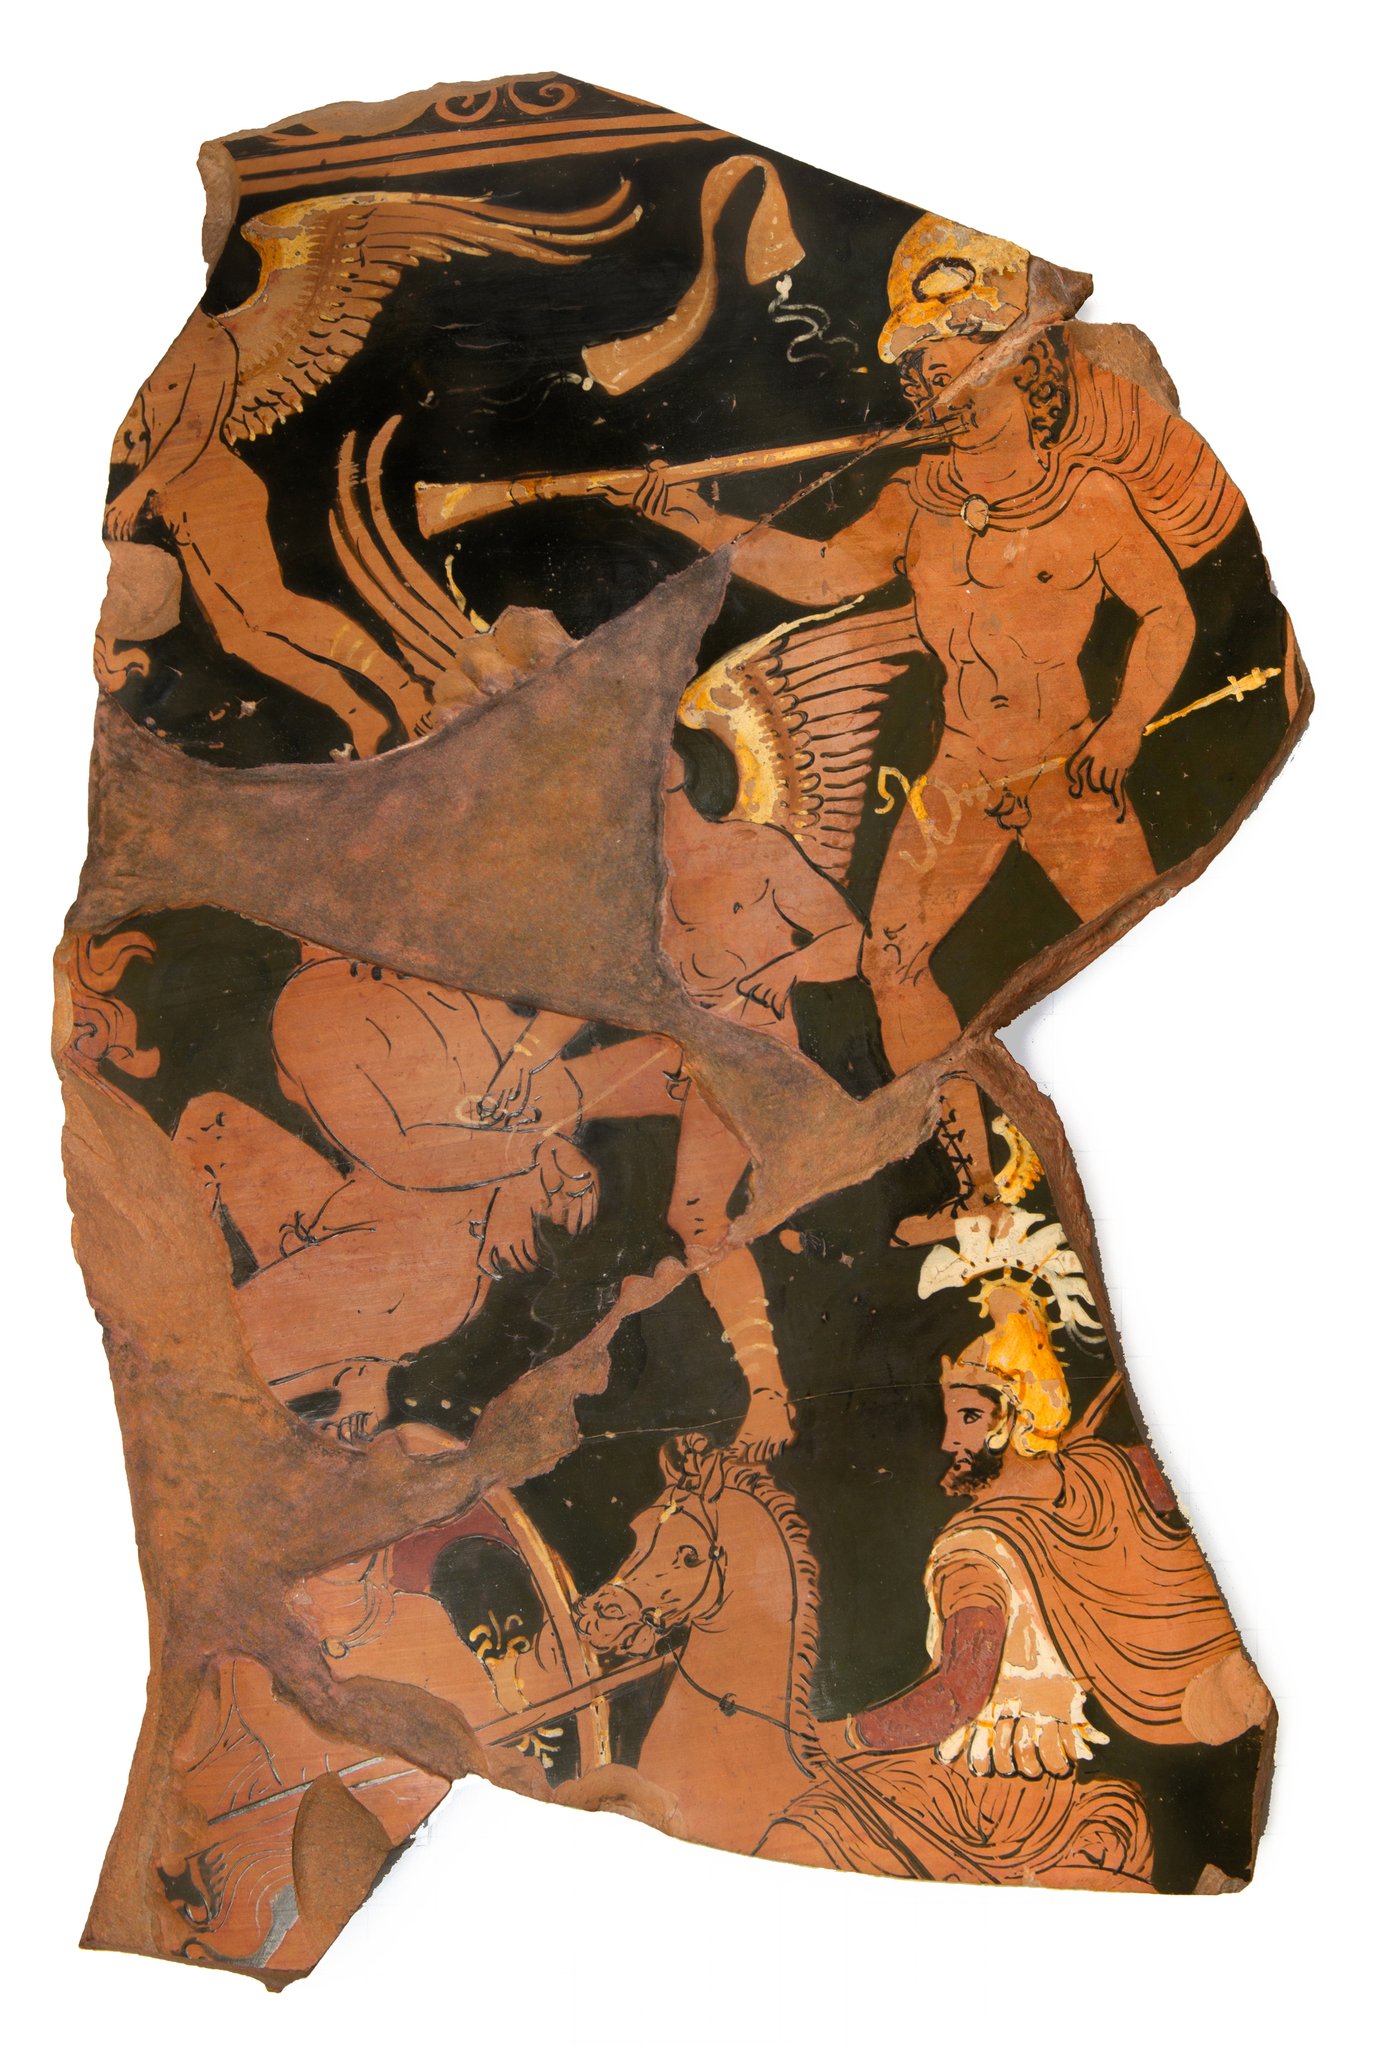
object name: volute krater fragment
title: Fragment of a terracotta volute-krater (bowl for mixing wine and water); joins 19.192.81.5,.11,.19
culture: greek, south italian, apulian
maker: baltimore painter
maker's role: artist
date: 325-301 BCE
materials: terracotta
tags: male nudes,trumpets,horses